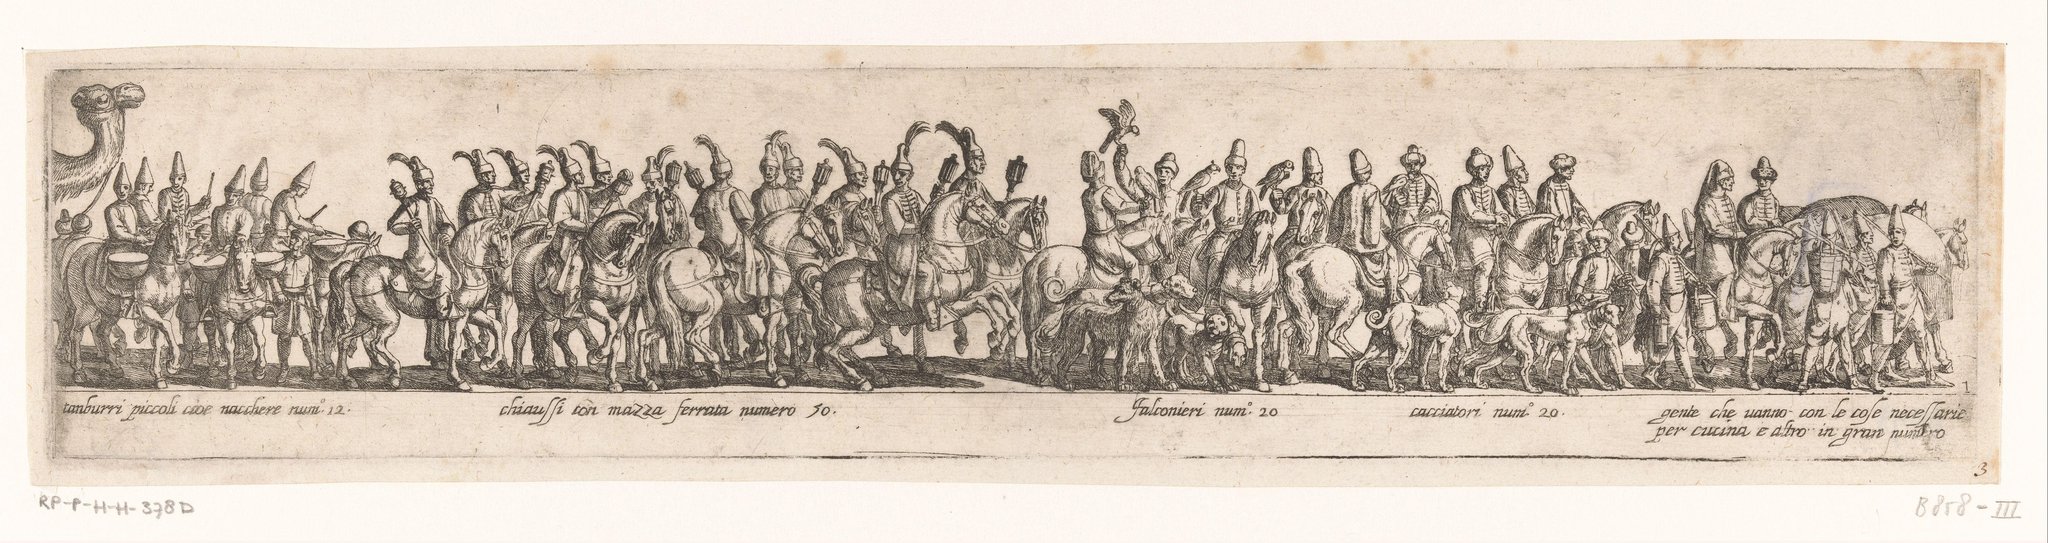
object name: print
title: Cavalcade voor vertrek van een sultan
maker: antonio tempesta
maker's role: draughtsman, painter, print maker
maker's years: 1555-1630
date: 1565-1630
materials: paper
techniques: etching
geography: vatican city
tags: ceremonial procession, parade, pageant ~ installation of a ruler, festivities (+ the public ~ festive activities), head-gear: turban, warfare; military affairs (+ cavalry, horsemen)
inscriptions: collector's mark: ‘Hinloopen’, number: ‘3’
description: Deel van een parade met paarden, kamelen, muzikanten en soldaten, vanwege het vertrek van een sultan. Bijschriften in het Italiaans in ondermarge.